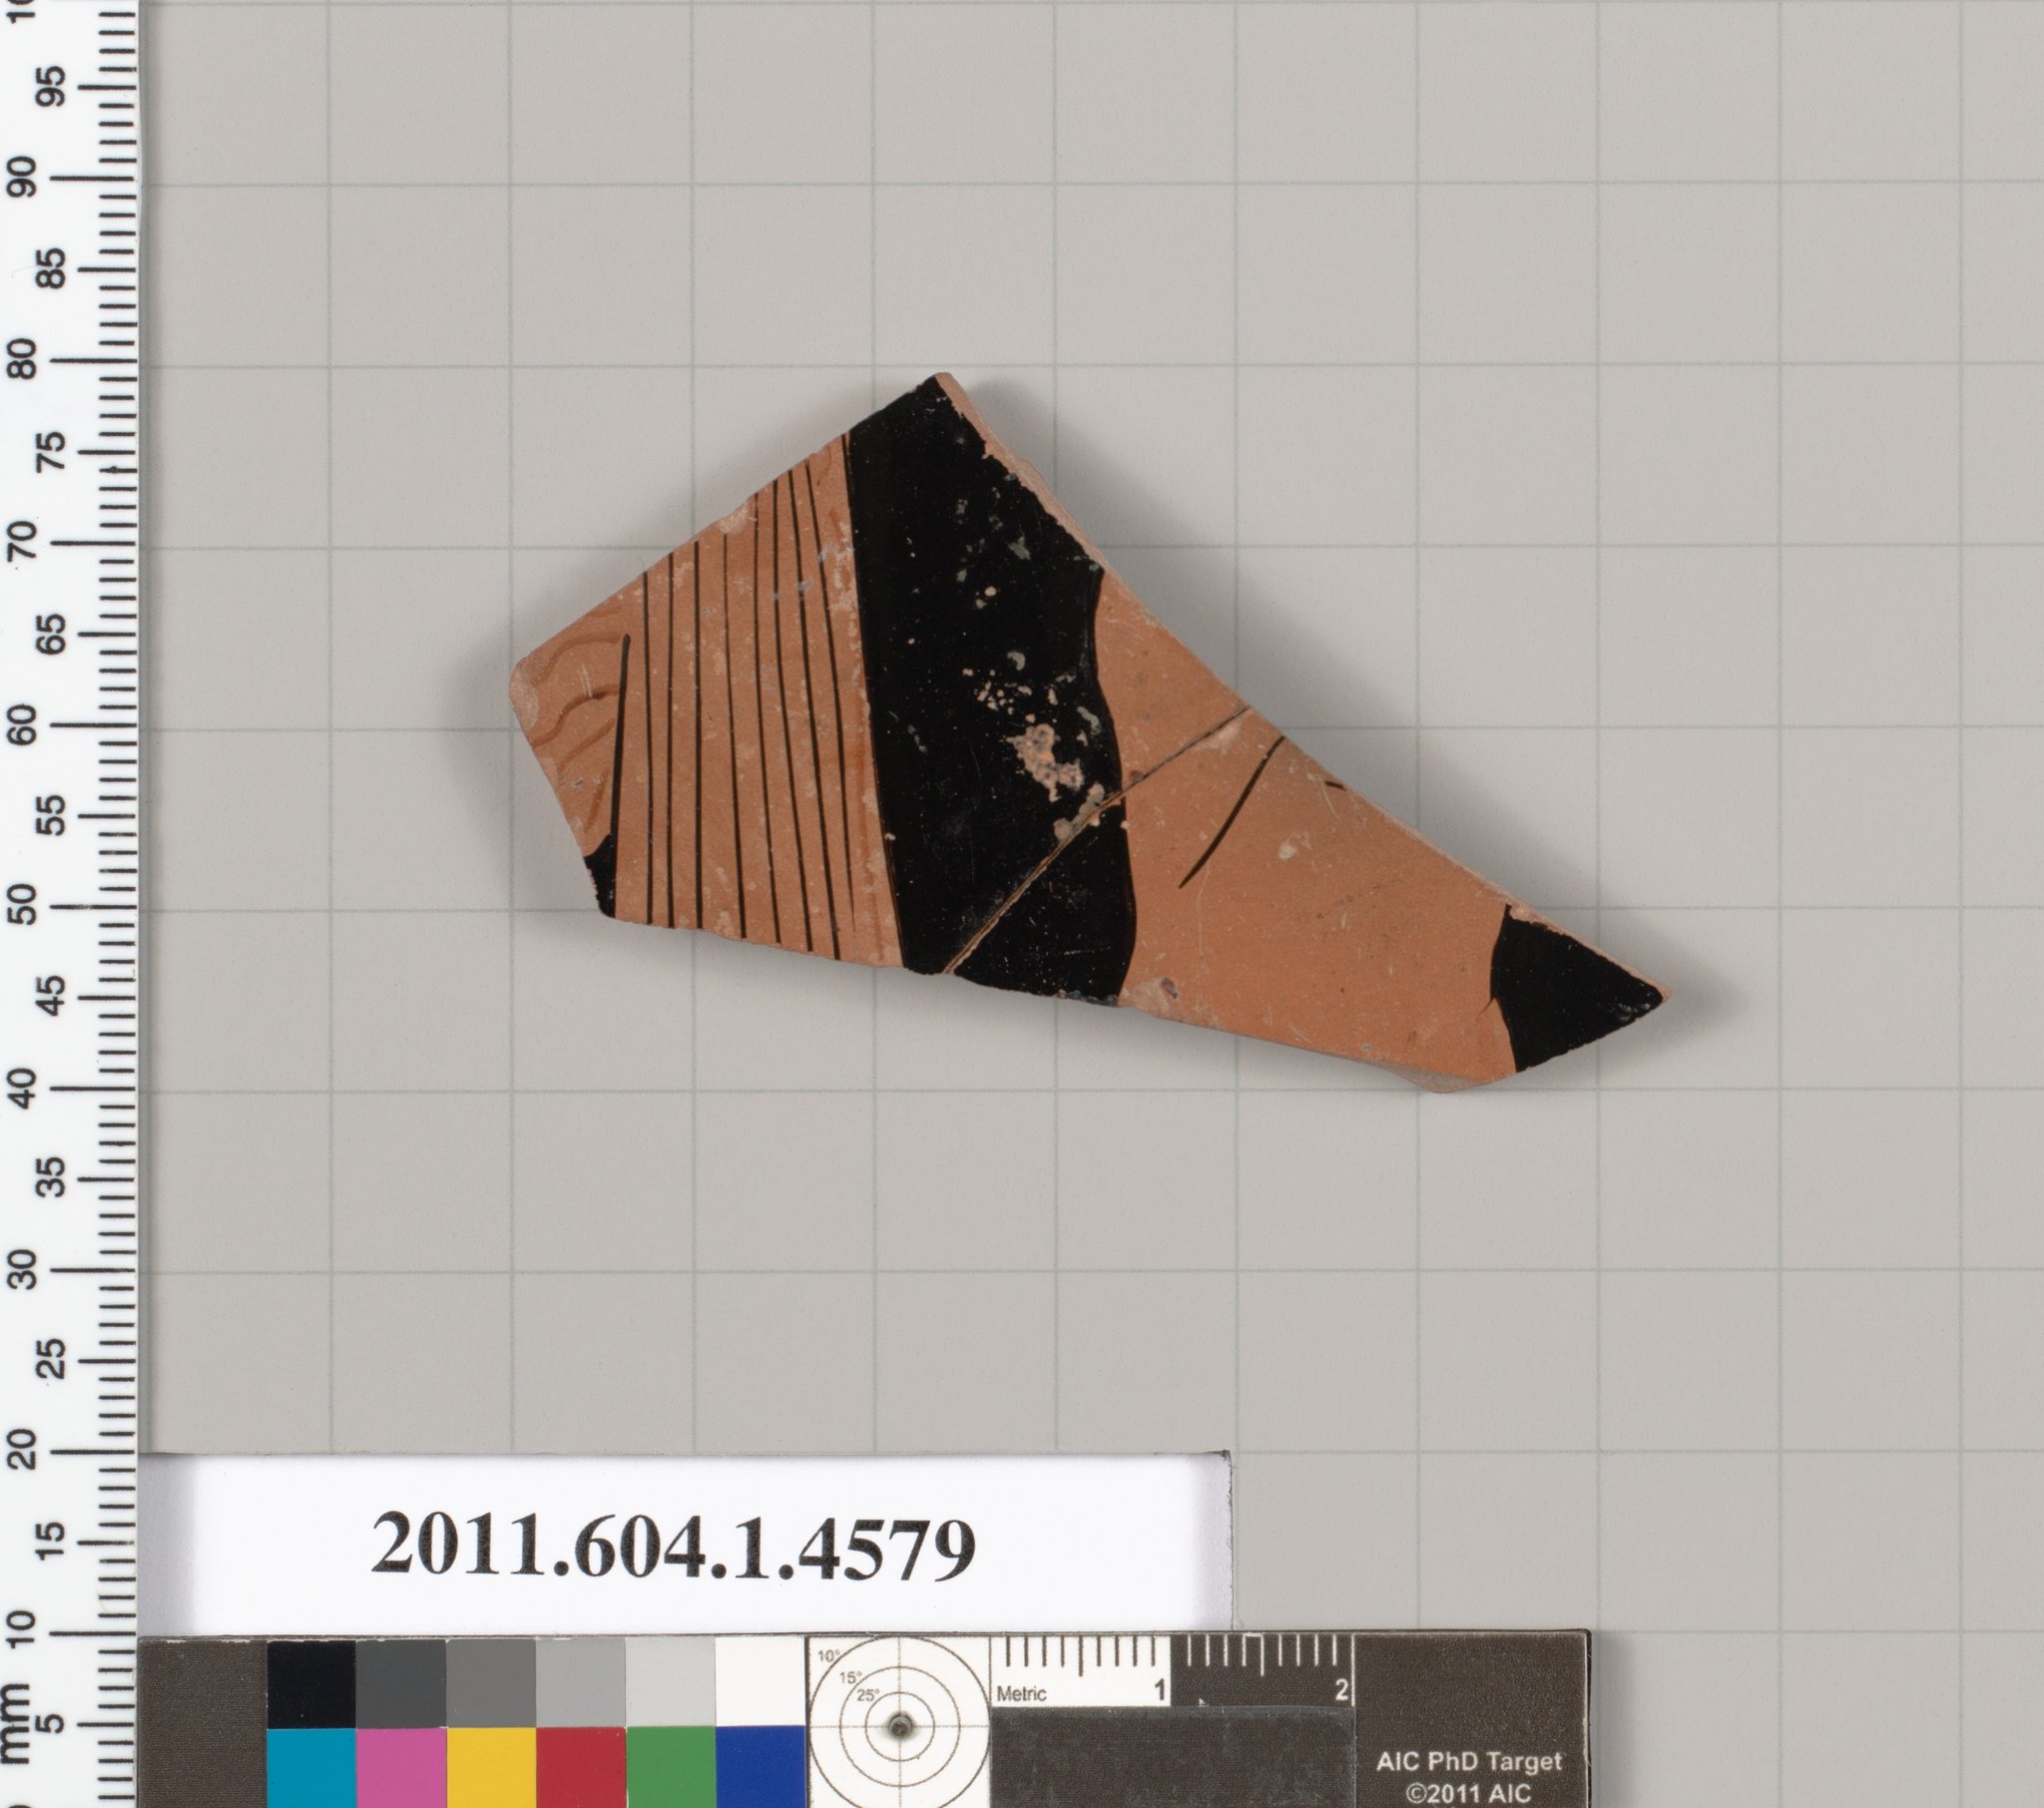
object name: kylix fragment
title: Terracotta fragment of a kylix (drinking cup)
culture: greek, attic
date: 480-470 BCE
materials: terracotta